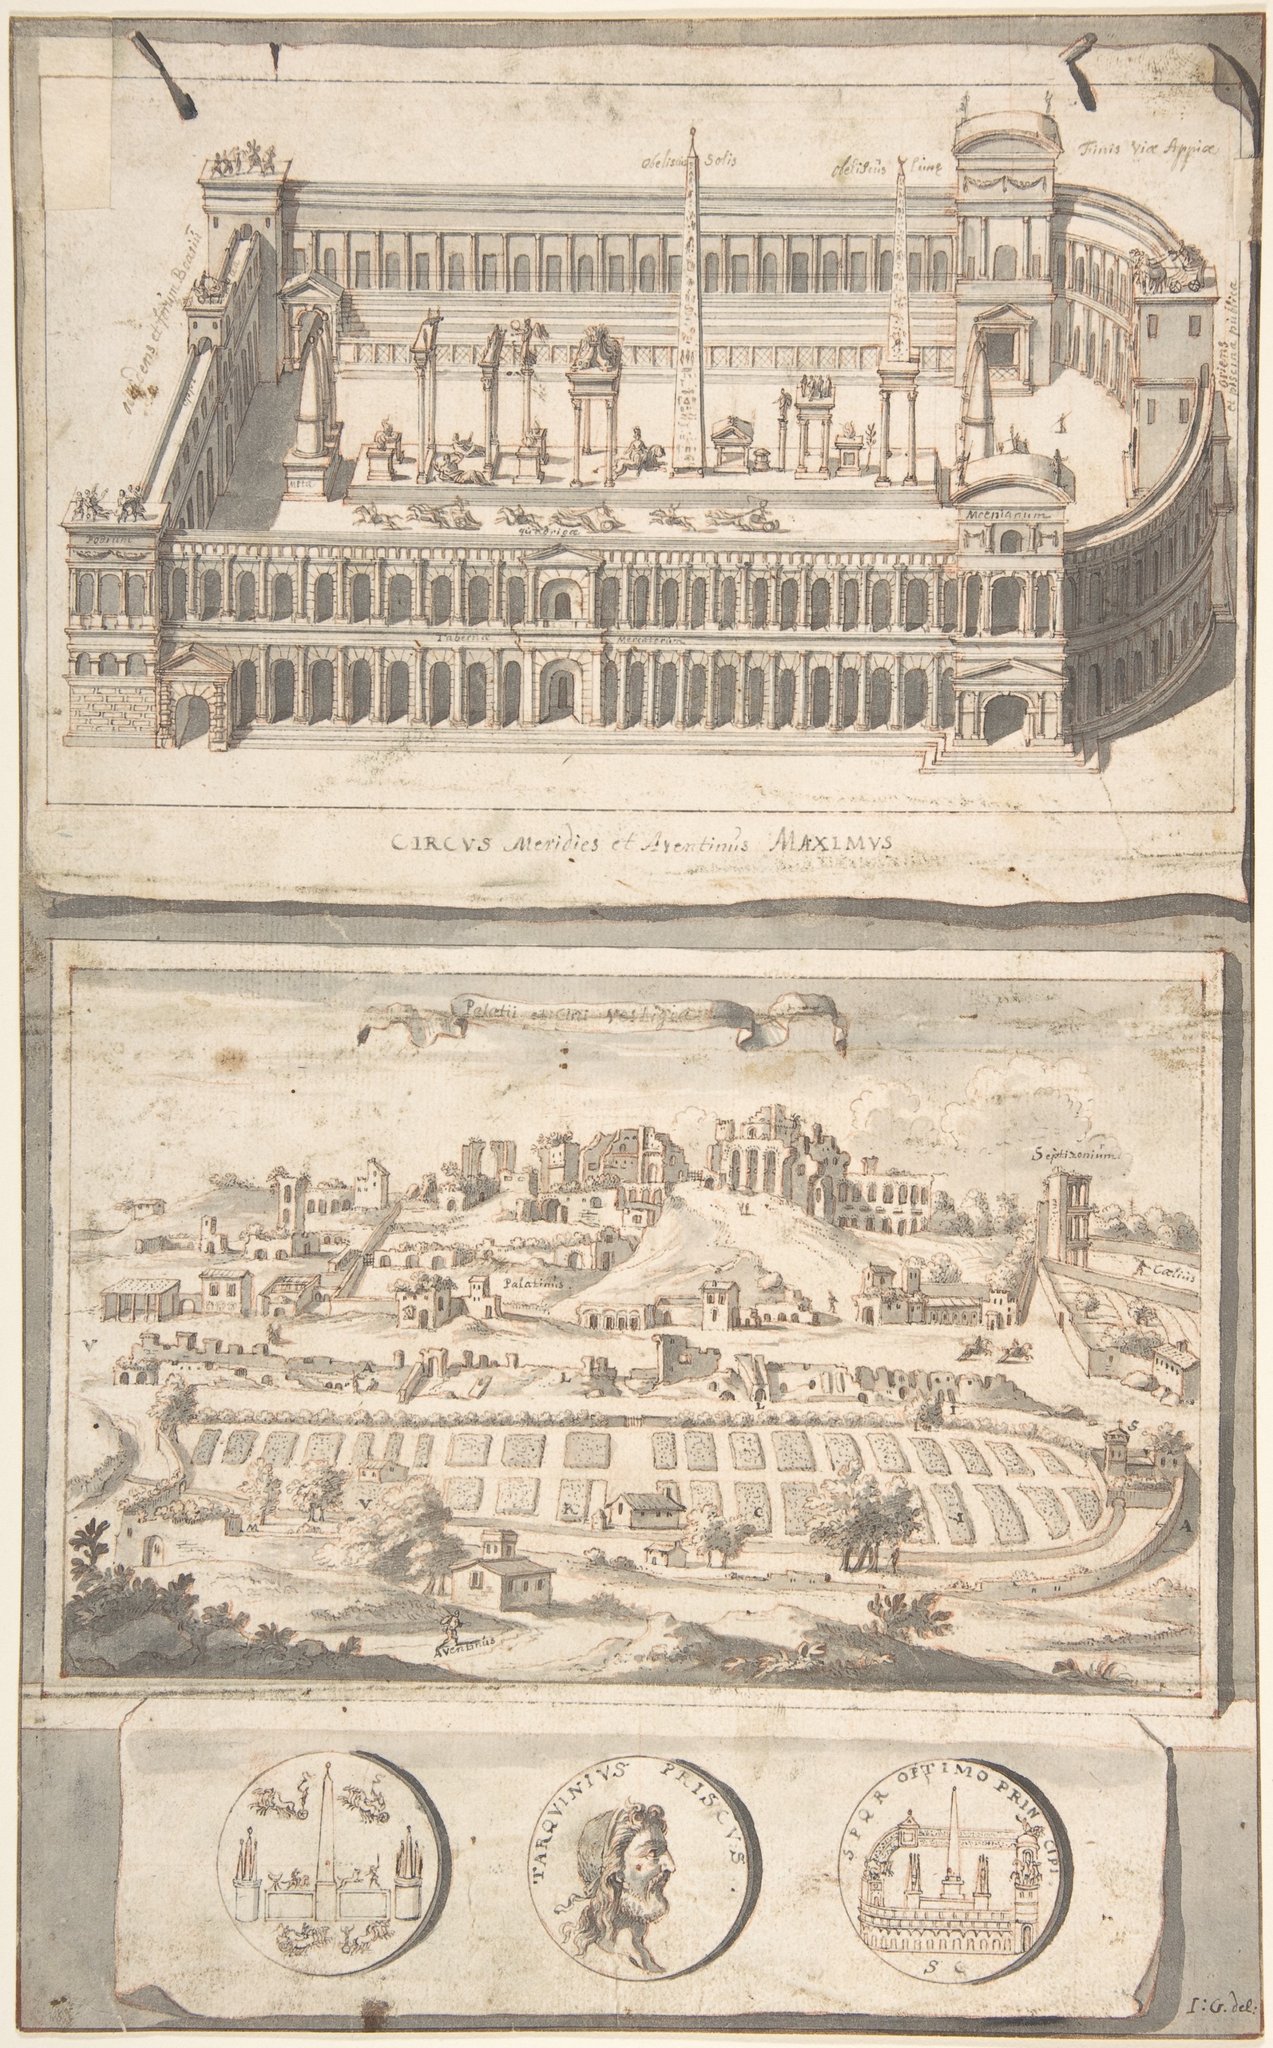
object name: drawing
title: Reconstruction of the Circus Maximus (above) and a View of the Site (below)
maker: jan goeree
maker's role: artist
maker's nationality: dutch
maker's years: 1670-1731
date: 1704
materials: chalk, ink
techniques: brush, pen, wash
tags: human figures,buildings